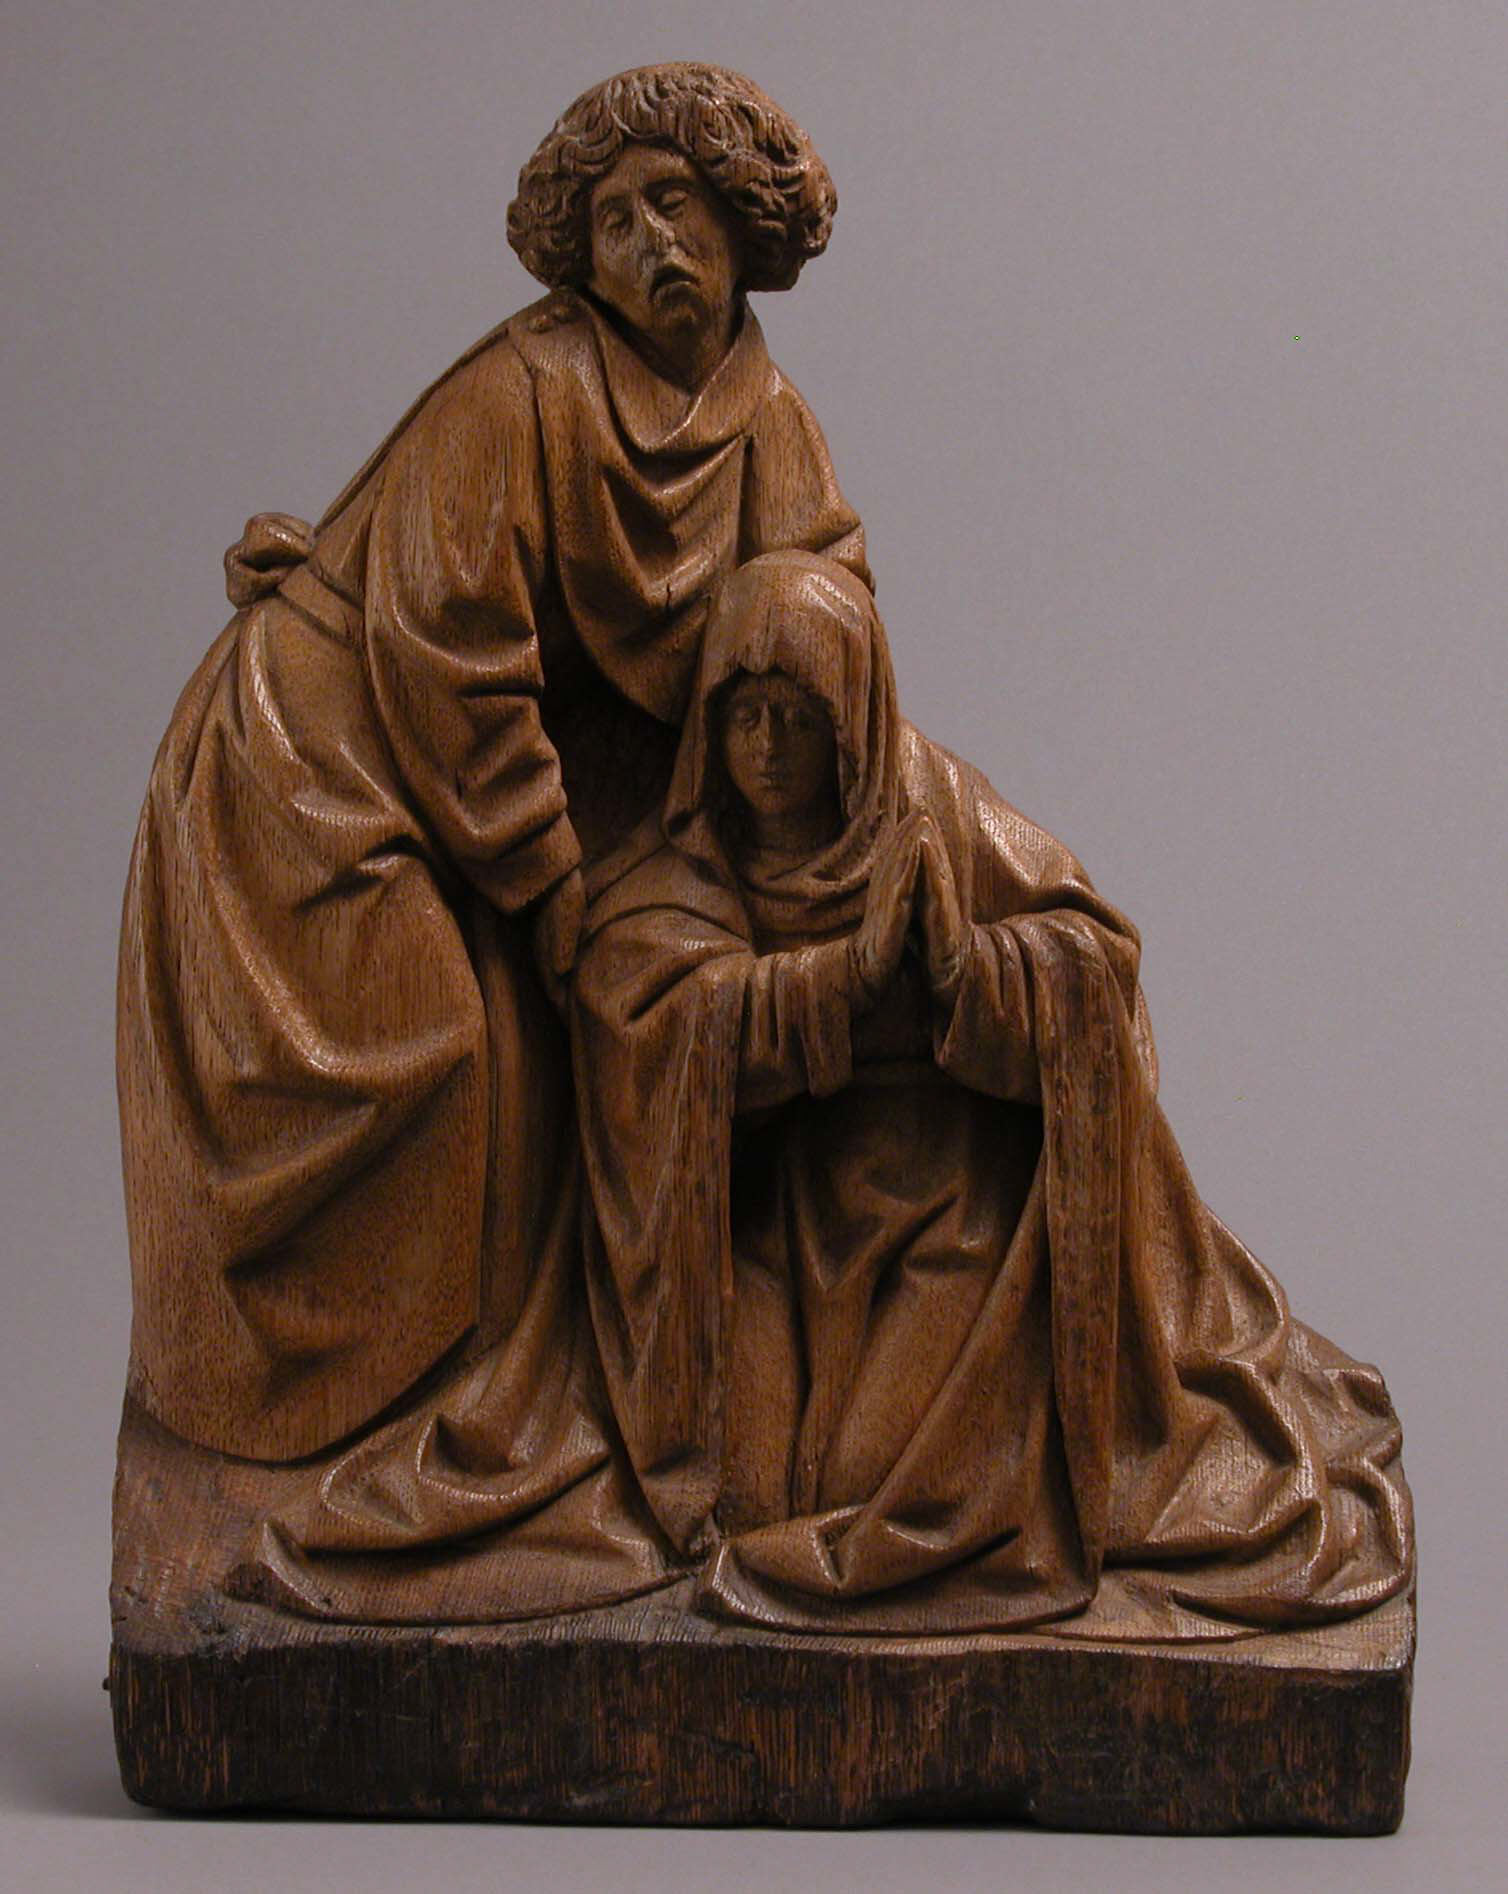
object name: statuette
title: Virgin Supported by Saint John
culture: south netherlandish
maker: school of antwerp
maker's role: artist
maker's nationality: south netherlandish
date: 1501-1533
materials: wood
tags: virgin mary,saint john